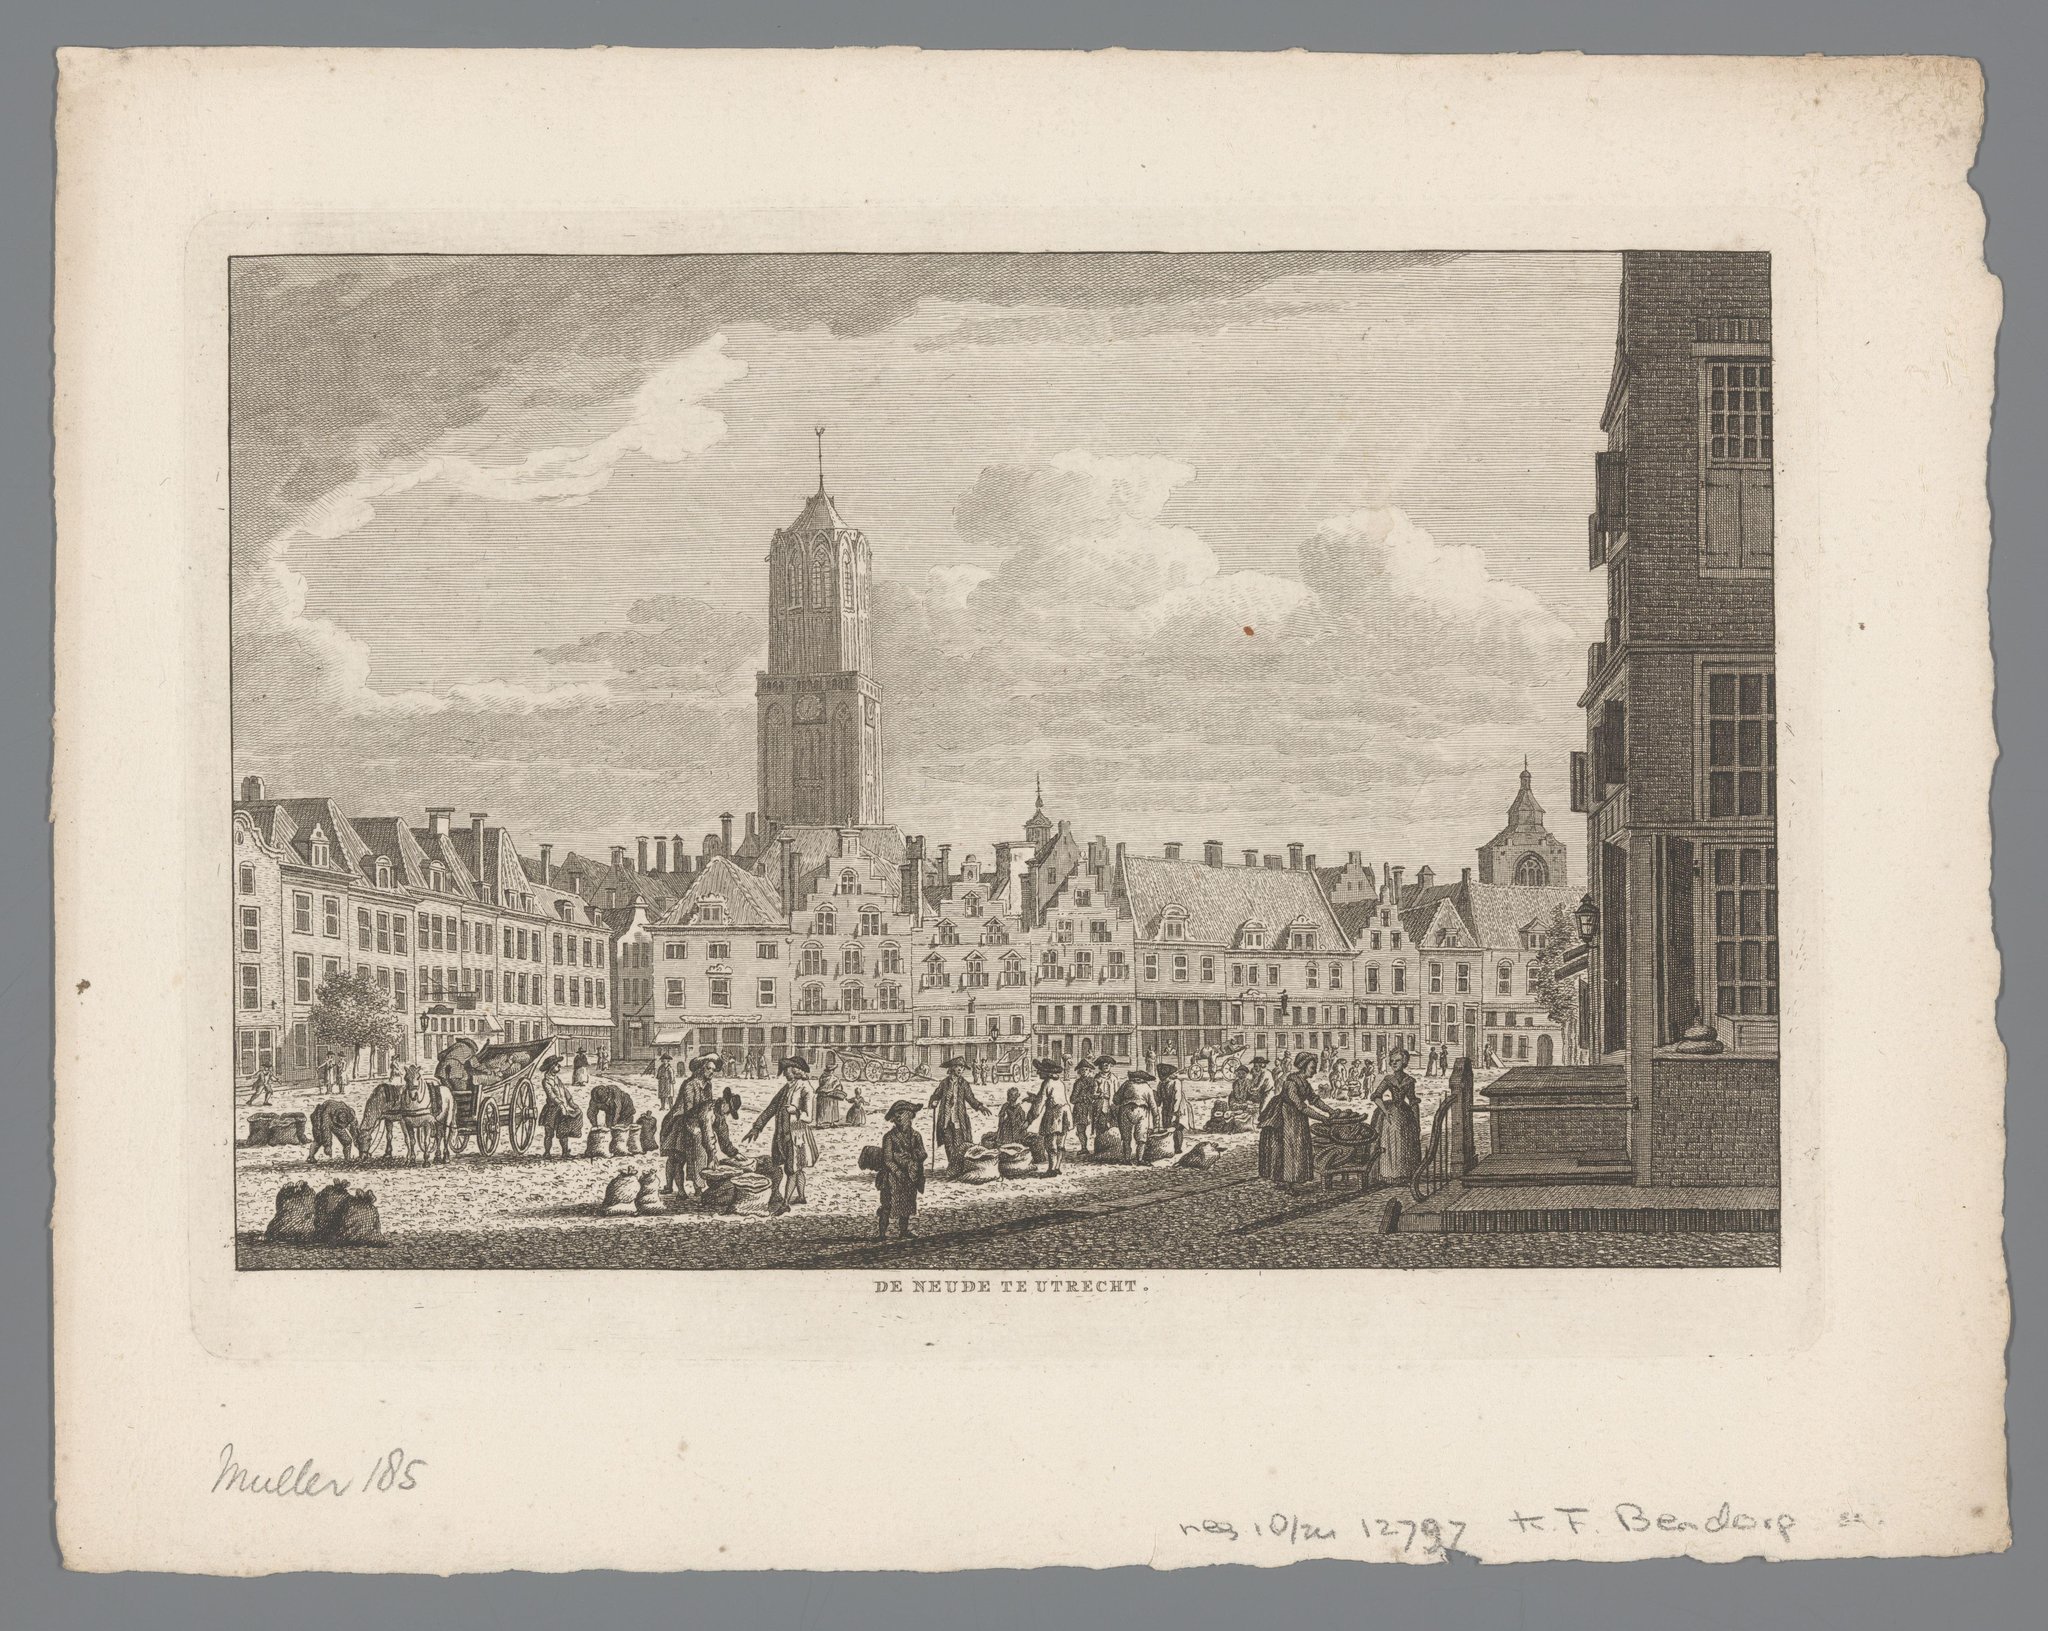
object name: print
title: Gezicht op de Neude te Utrecht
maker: carel frederik bendorp (i)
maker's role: print maker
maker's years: 1736-1814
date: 1786-1792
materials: paper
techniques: etching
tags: city-view in general; 'veduta', village square, place, utrecht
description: Prent uit: Vaderlandsche gezichten, of afbeeldingen van den tegenwoordigen staat der Vereenigde Nederlanden (…). Amsterdam: Hendrik Gartman, Willem Vermandel en Jan Willem Smit, 1786-1792. Uitgegeven in afleveringen met ieder een eigen bifolium en inhoudsopgave. Alle prenten in deze publicatie zijn gegraveerd door Carel Frederik Bendorp (I) en, in de meeste gevallen, gebaseerd op tekeningen van Jan Bulthuis.